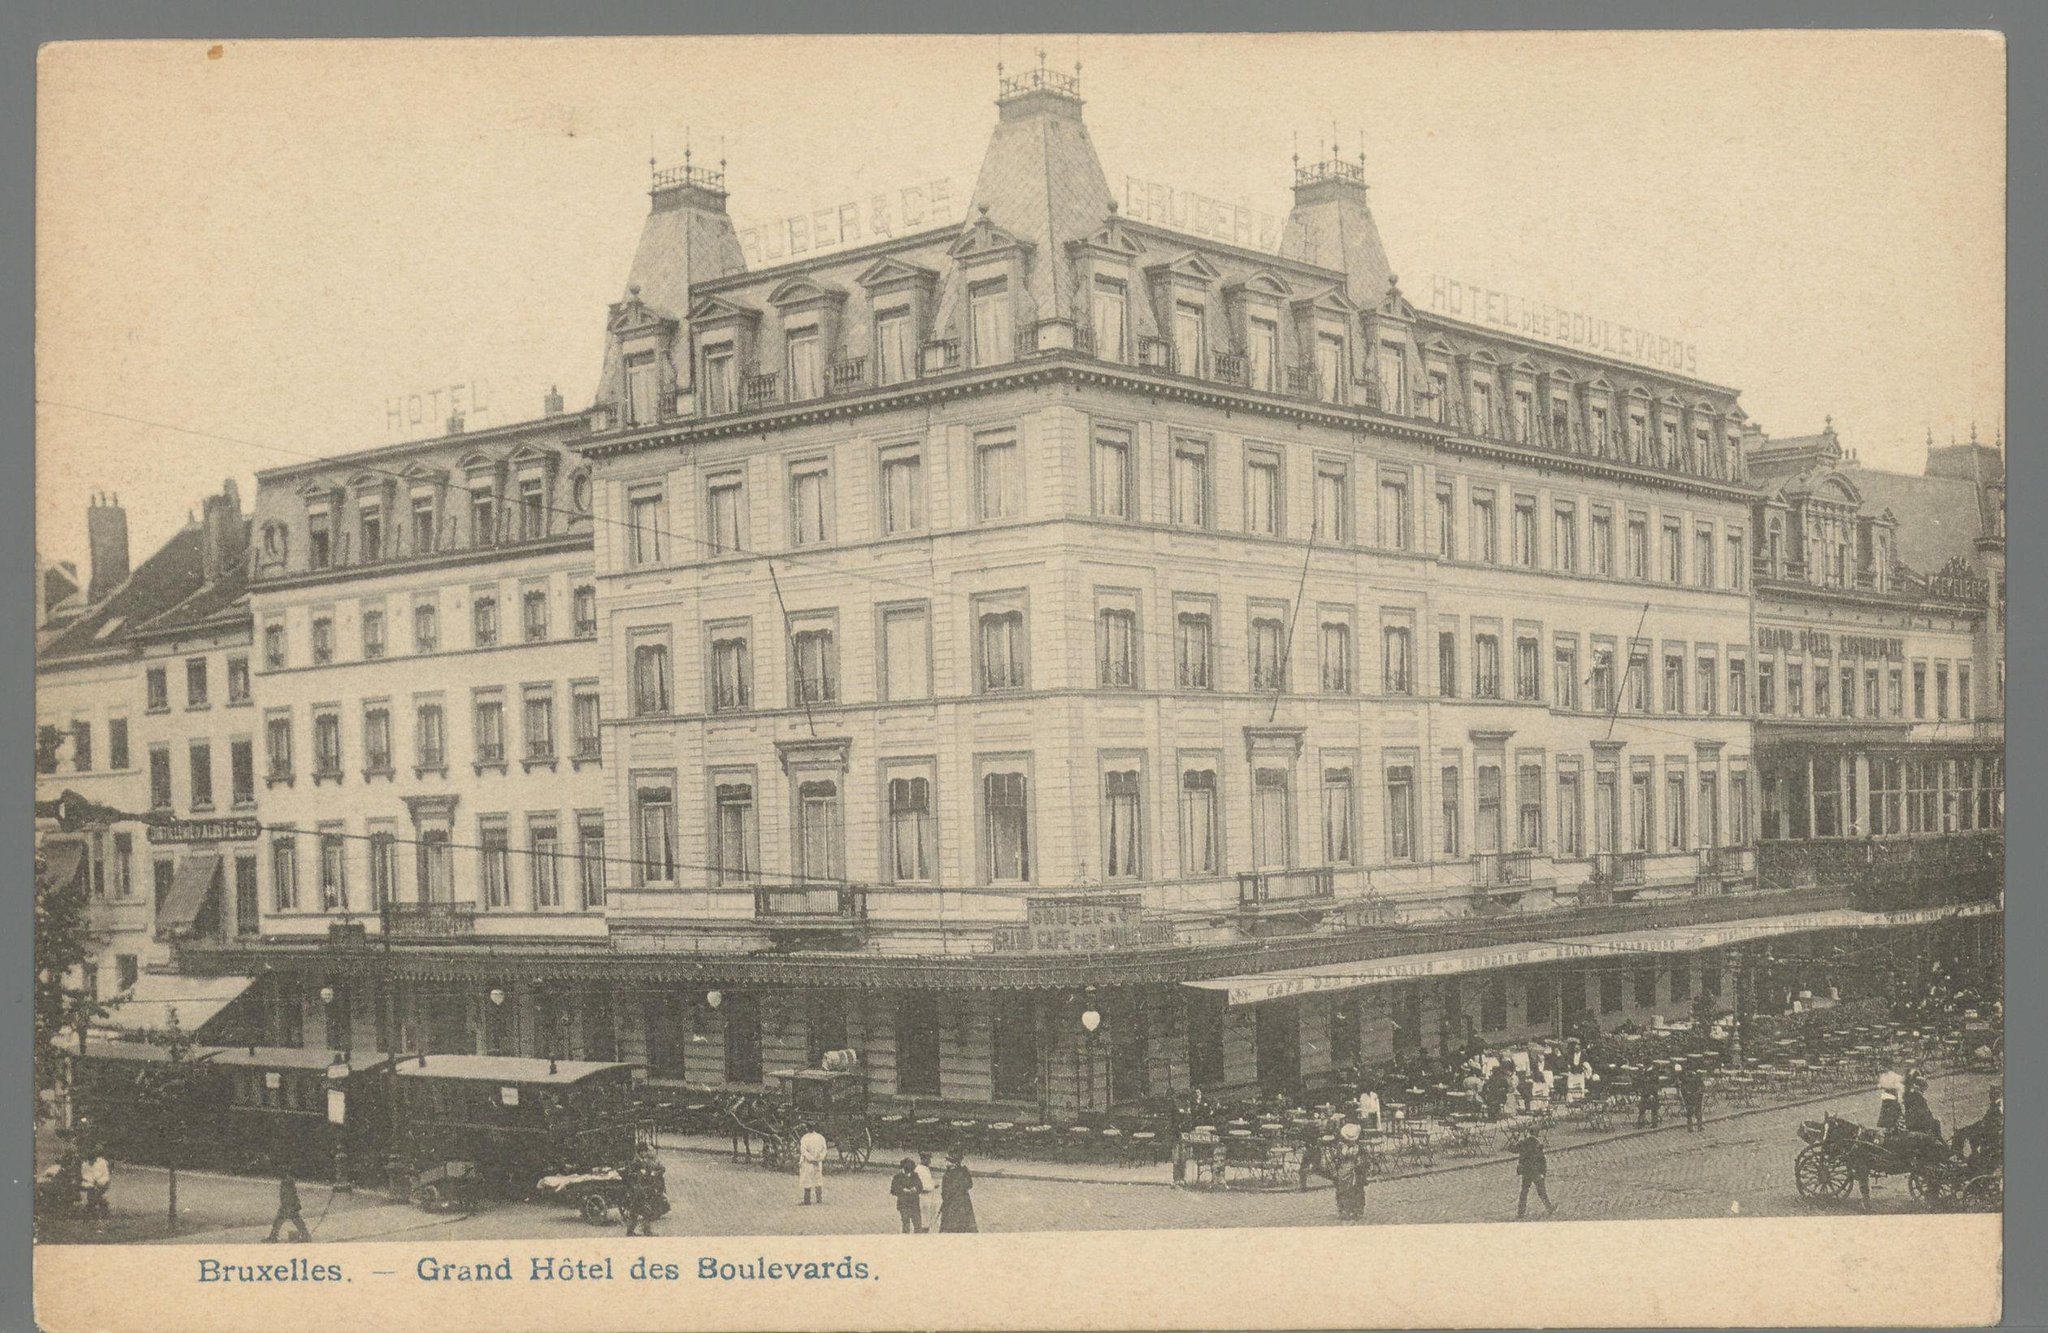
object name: photomechanical print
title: Bruxelles. Grand Hôtel des Boulevards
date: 1906-1914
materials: cardboard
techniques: photograph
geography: schaarbeek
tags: avenue, boulevard, promenade, esplanade (+ city(-scape) with figures, staffage), hotel, hostelry, inn, brussels